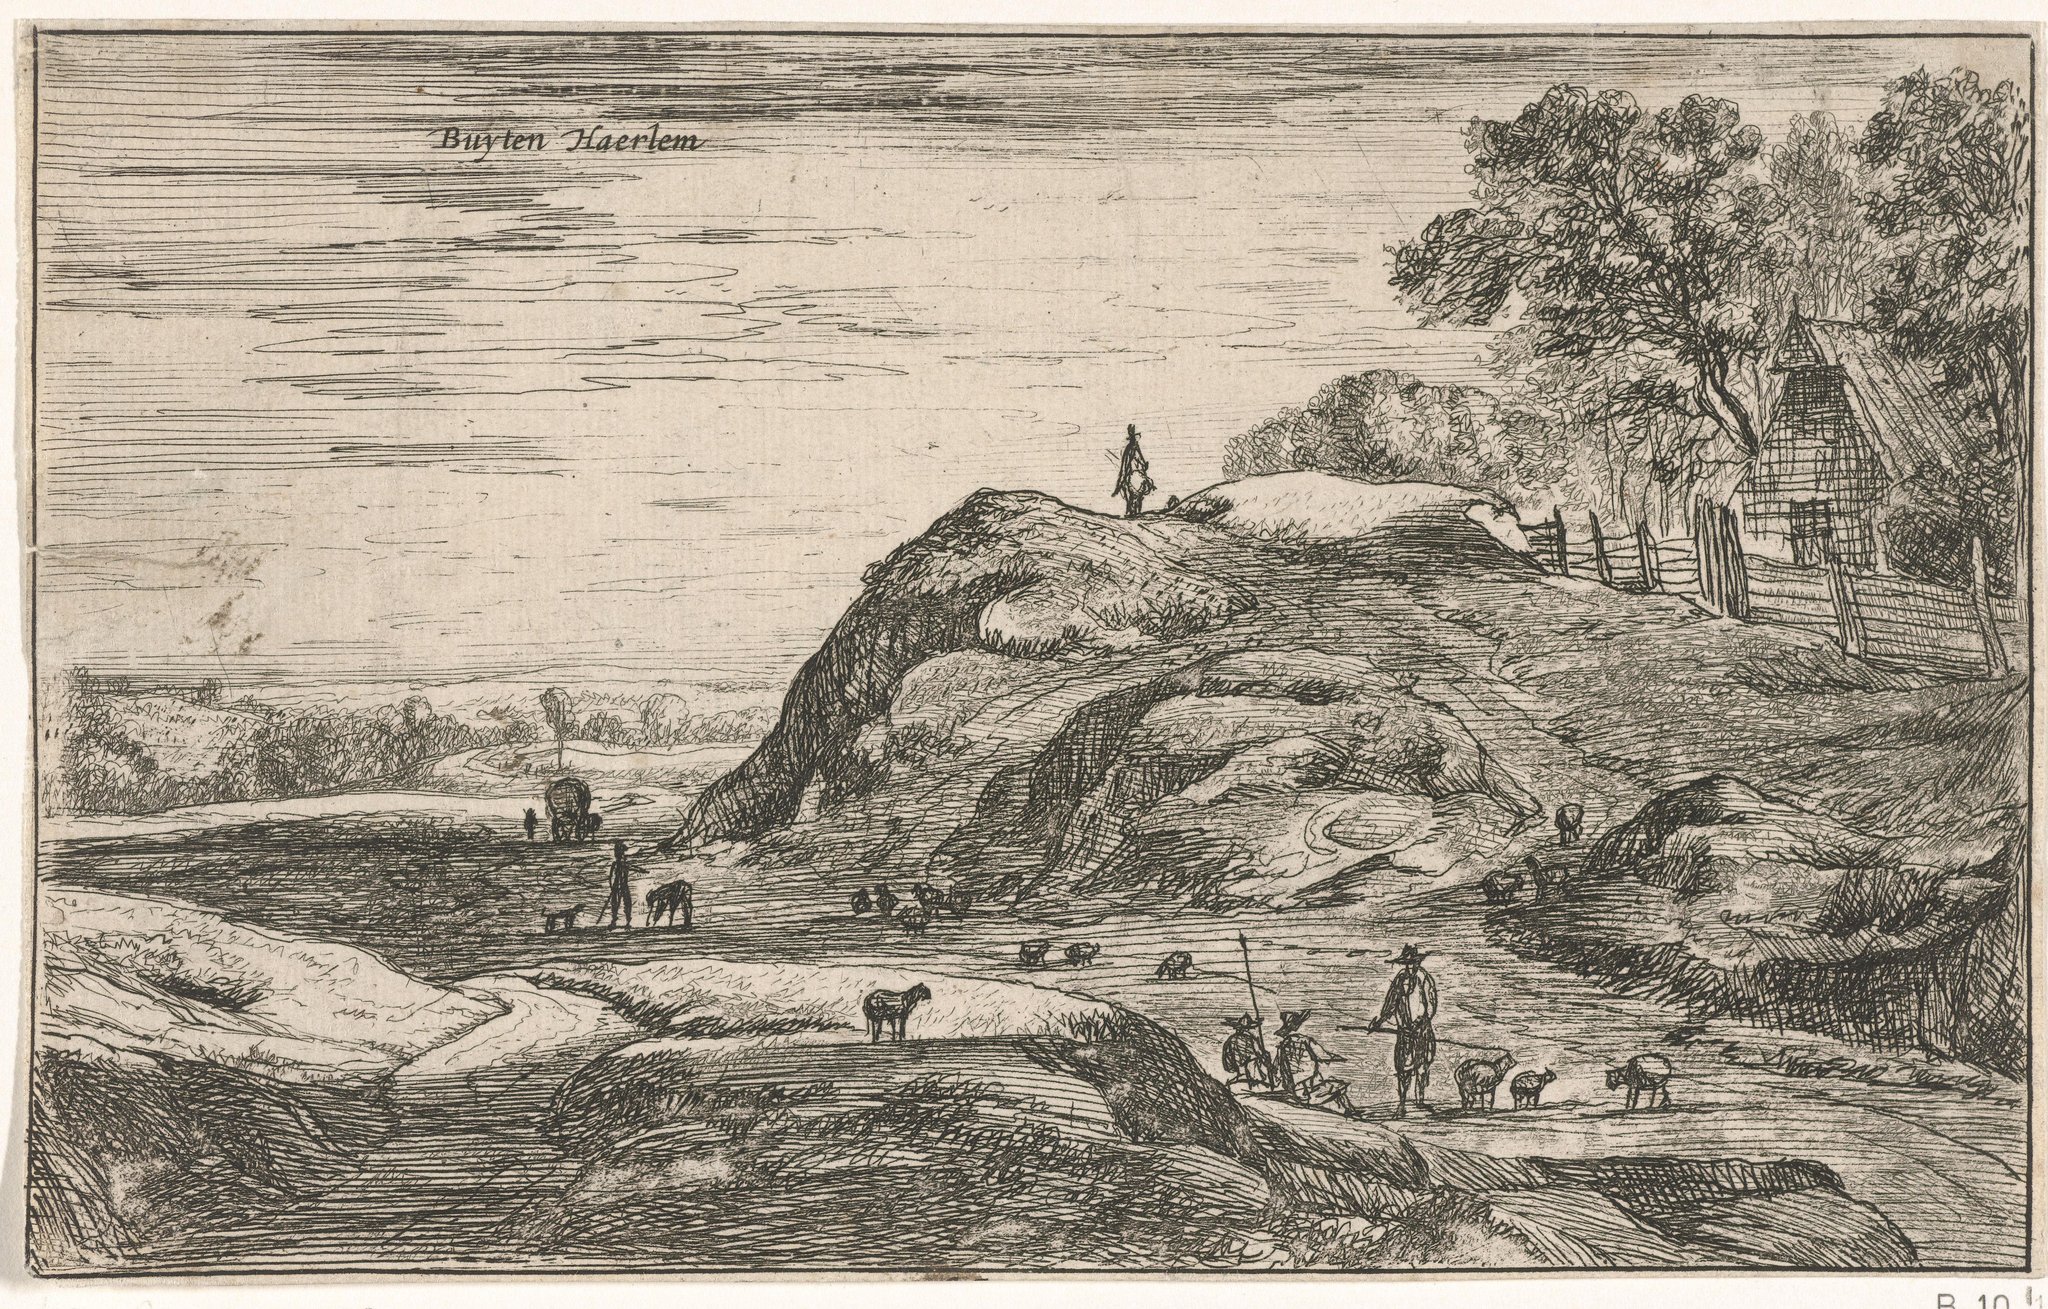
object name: print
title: Landschappen in de Noordelijke Nederlanden (Roelant Roghman)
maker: roelant roghman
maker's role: draughtsman, painter, print maker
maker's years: 1627-1692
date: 1637-1677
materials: paper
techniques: etching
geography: amsterdam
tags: farm or solitary house in landscape - ii - ideal landscapes, low hill country, herding, herdsman, herdswoman, shepherd, shepherdess, cowherd, etc., sheep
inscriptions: collector's mark: Lugt 2228a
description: Gezicht op een heuvelachtig landschap met herders en schapen, in de omgeving van Haarlem. Rechts op de heuvel een woning met een omheining.